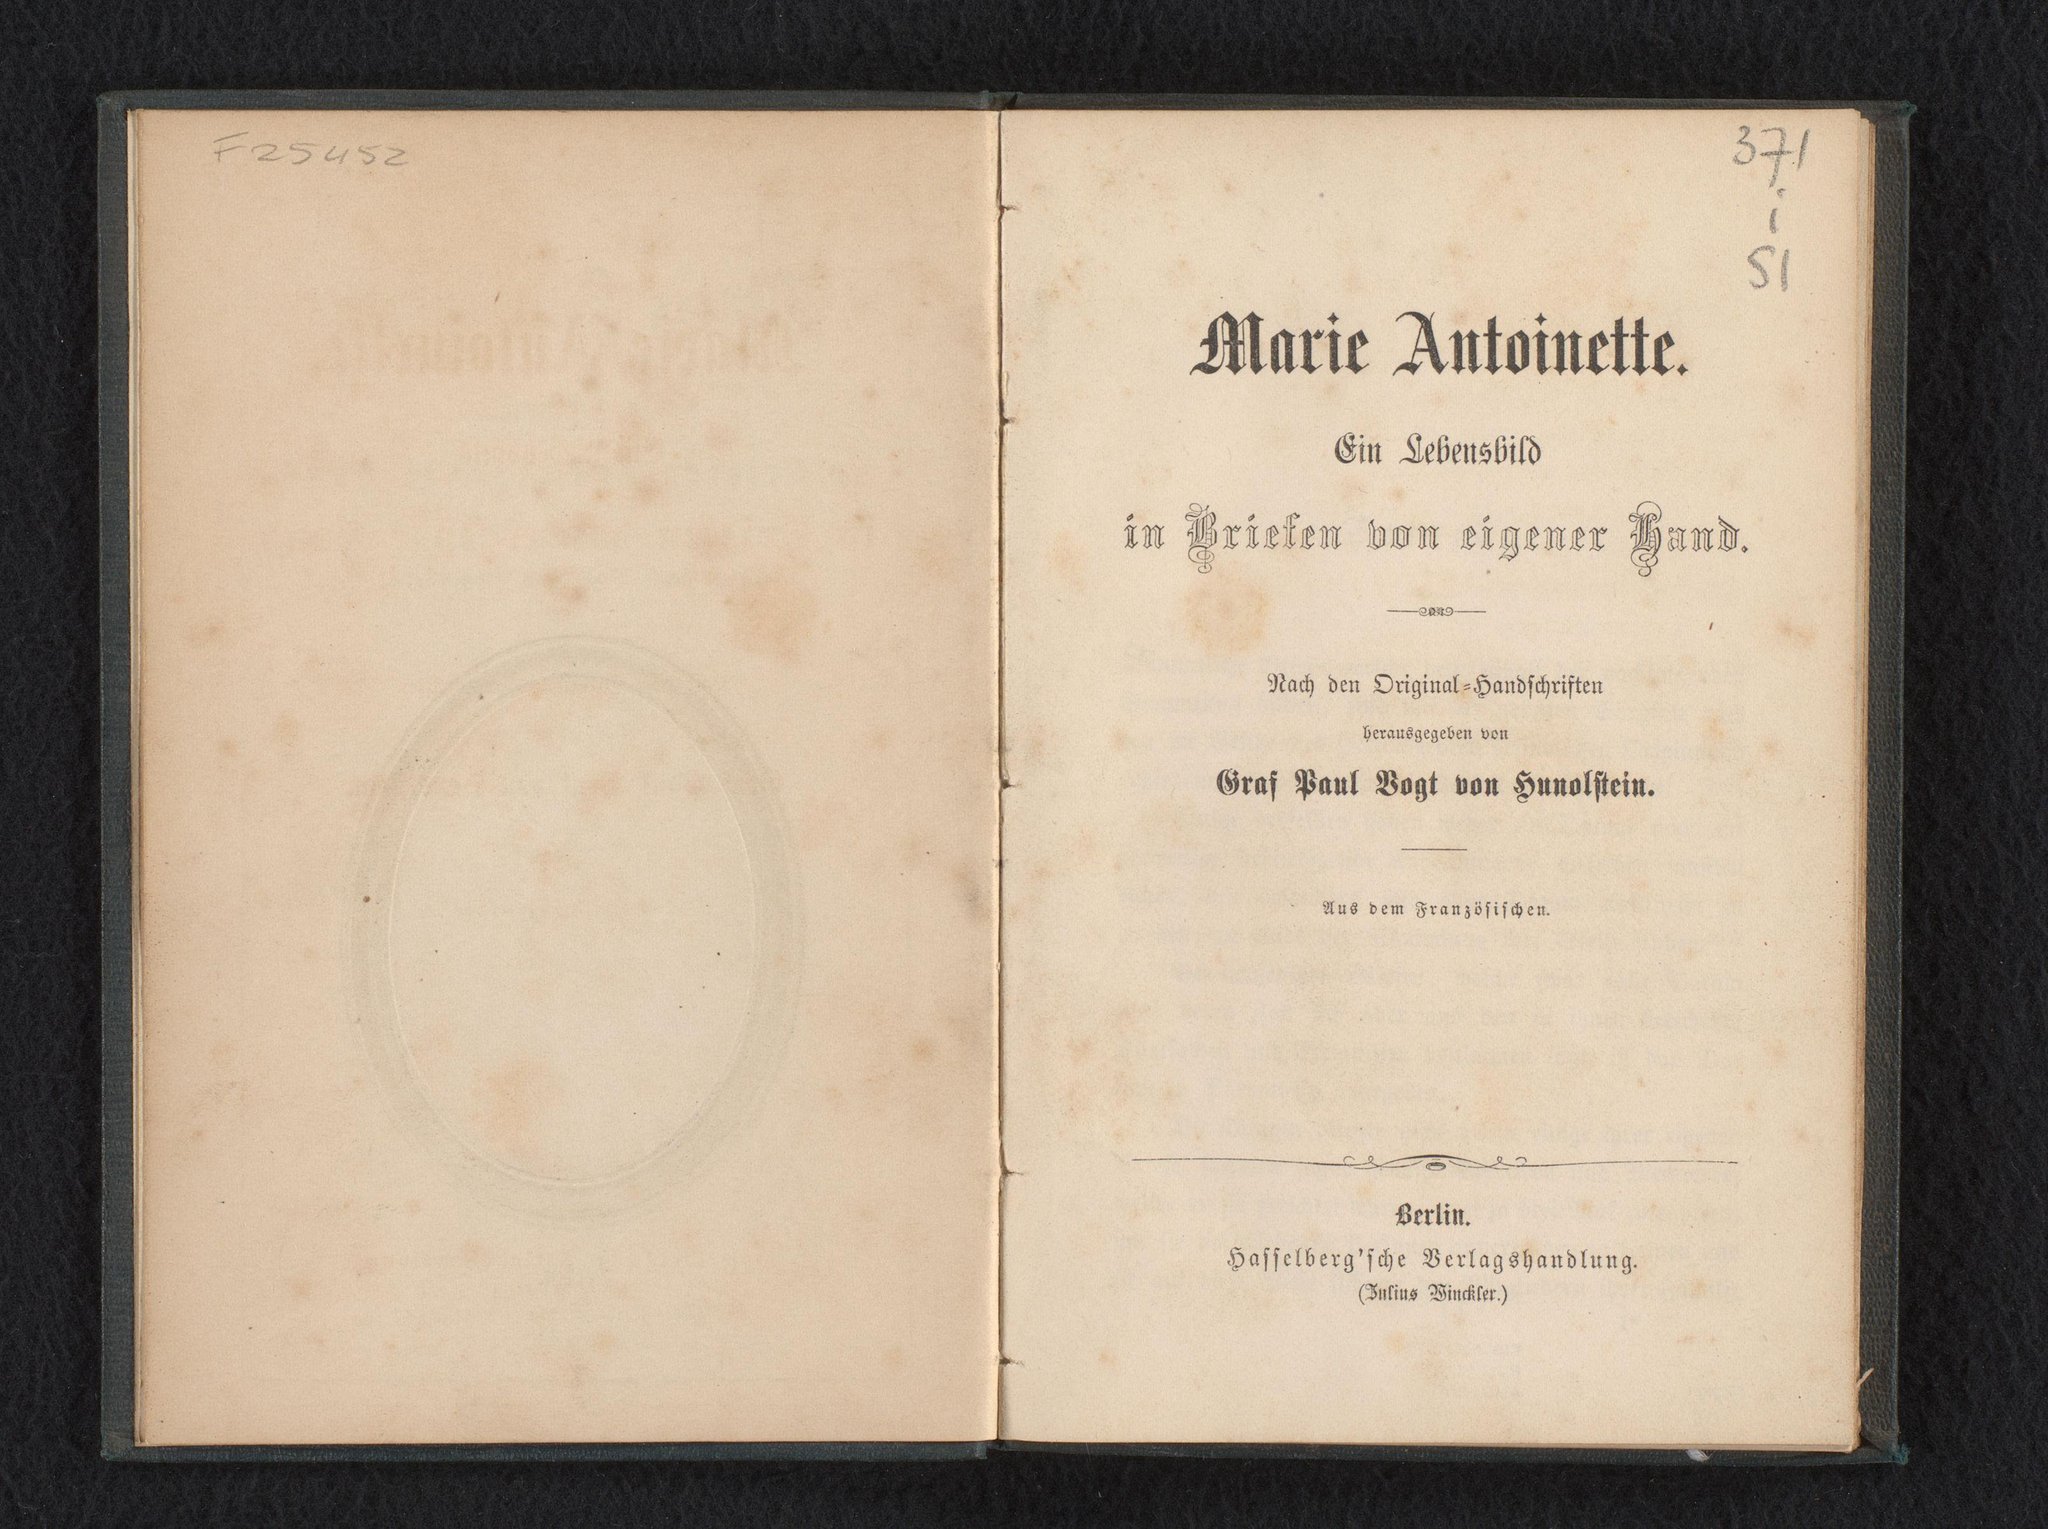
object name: book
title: Marie Antoinette: ein Lebensbild in Briefen von eigener Hand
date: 1865-1875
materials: cardboard, paper, textile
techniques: albumen print, letterpress printing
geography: berlin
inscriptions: number: ‘204’, inscription: ‘25,-/ 3.2836/ medaillon on title in photography/ (c. 1875)’